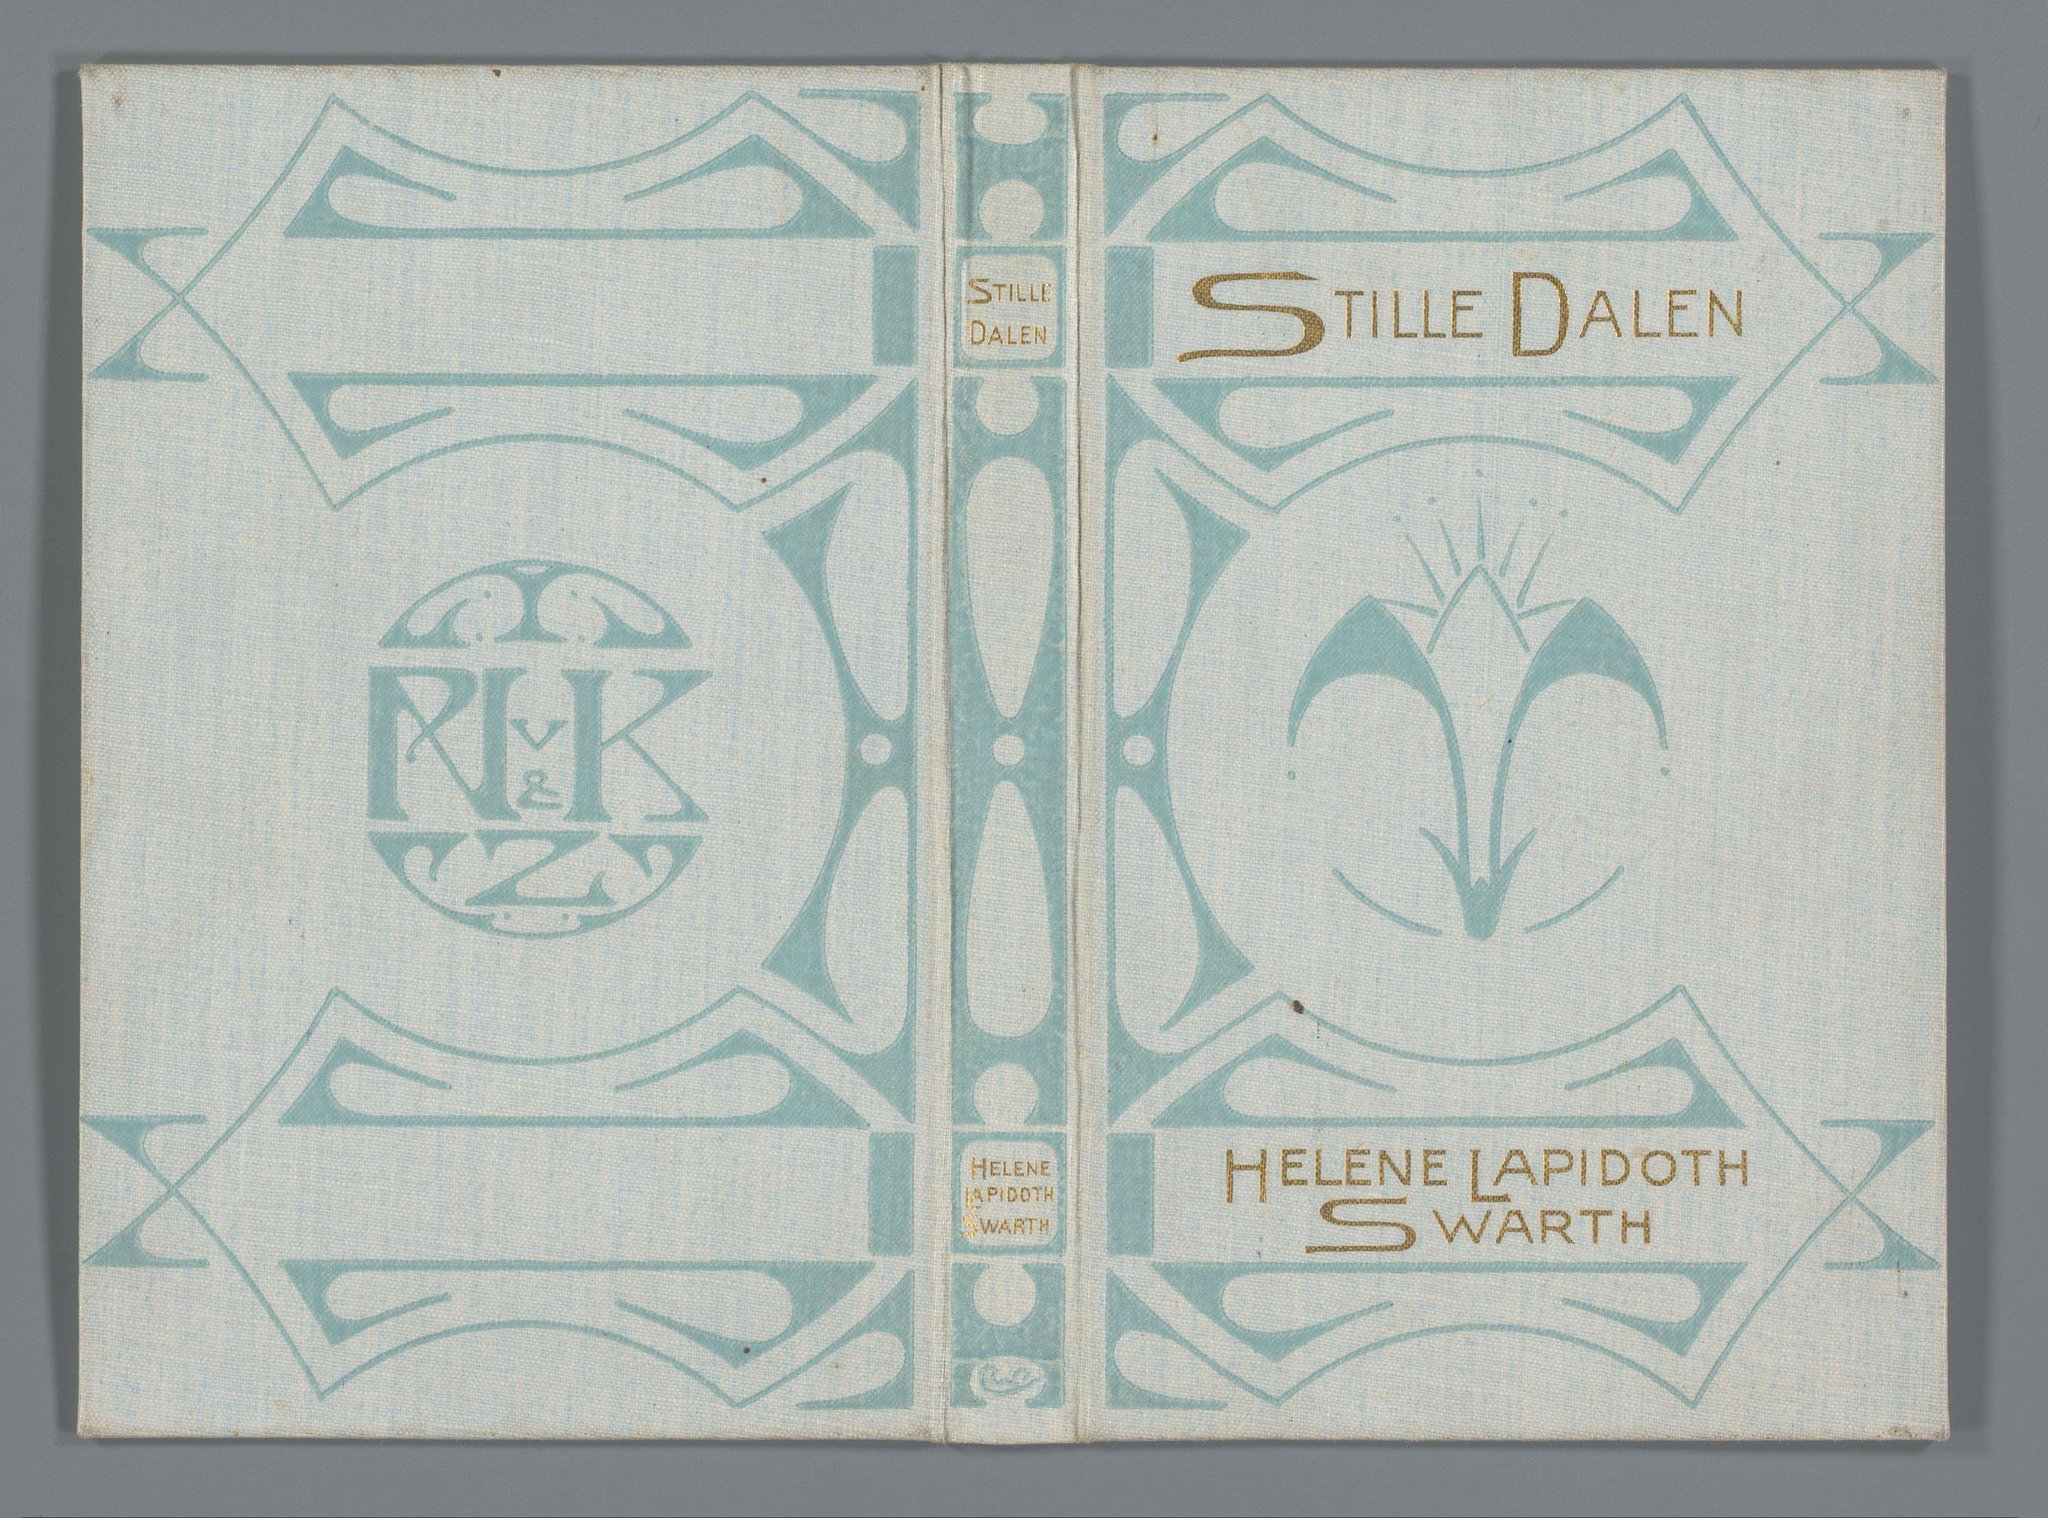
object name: binding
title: Boekband voor: Hélène Lapidoth-Swarth, Stille dalen, 1898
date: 1898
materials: cardboard, linen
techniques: printing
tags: ornaments ~ art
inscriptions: number: ‘5’, collector's mark: ‘R:MVS.’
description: Bandontwerp voor: Lapidoth-Swarth, Hélène. Stille dalen. Amsterdam: Van Kampen, 1898.